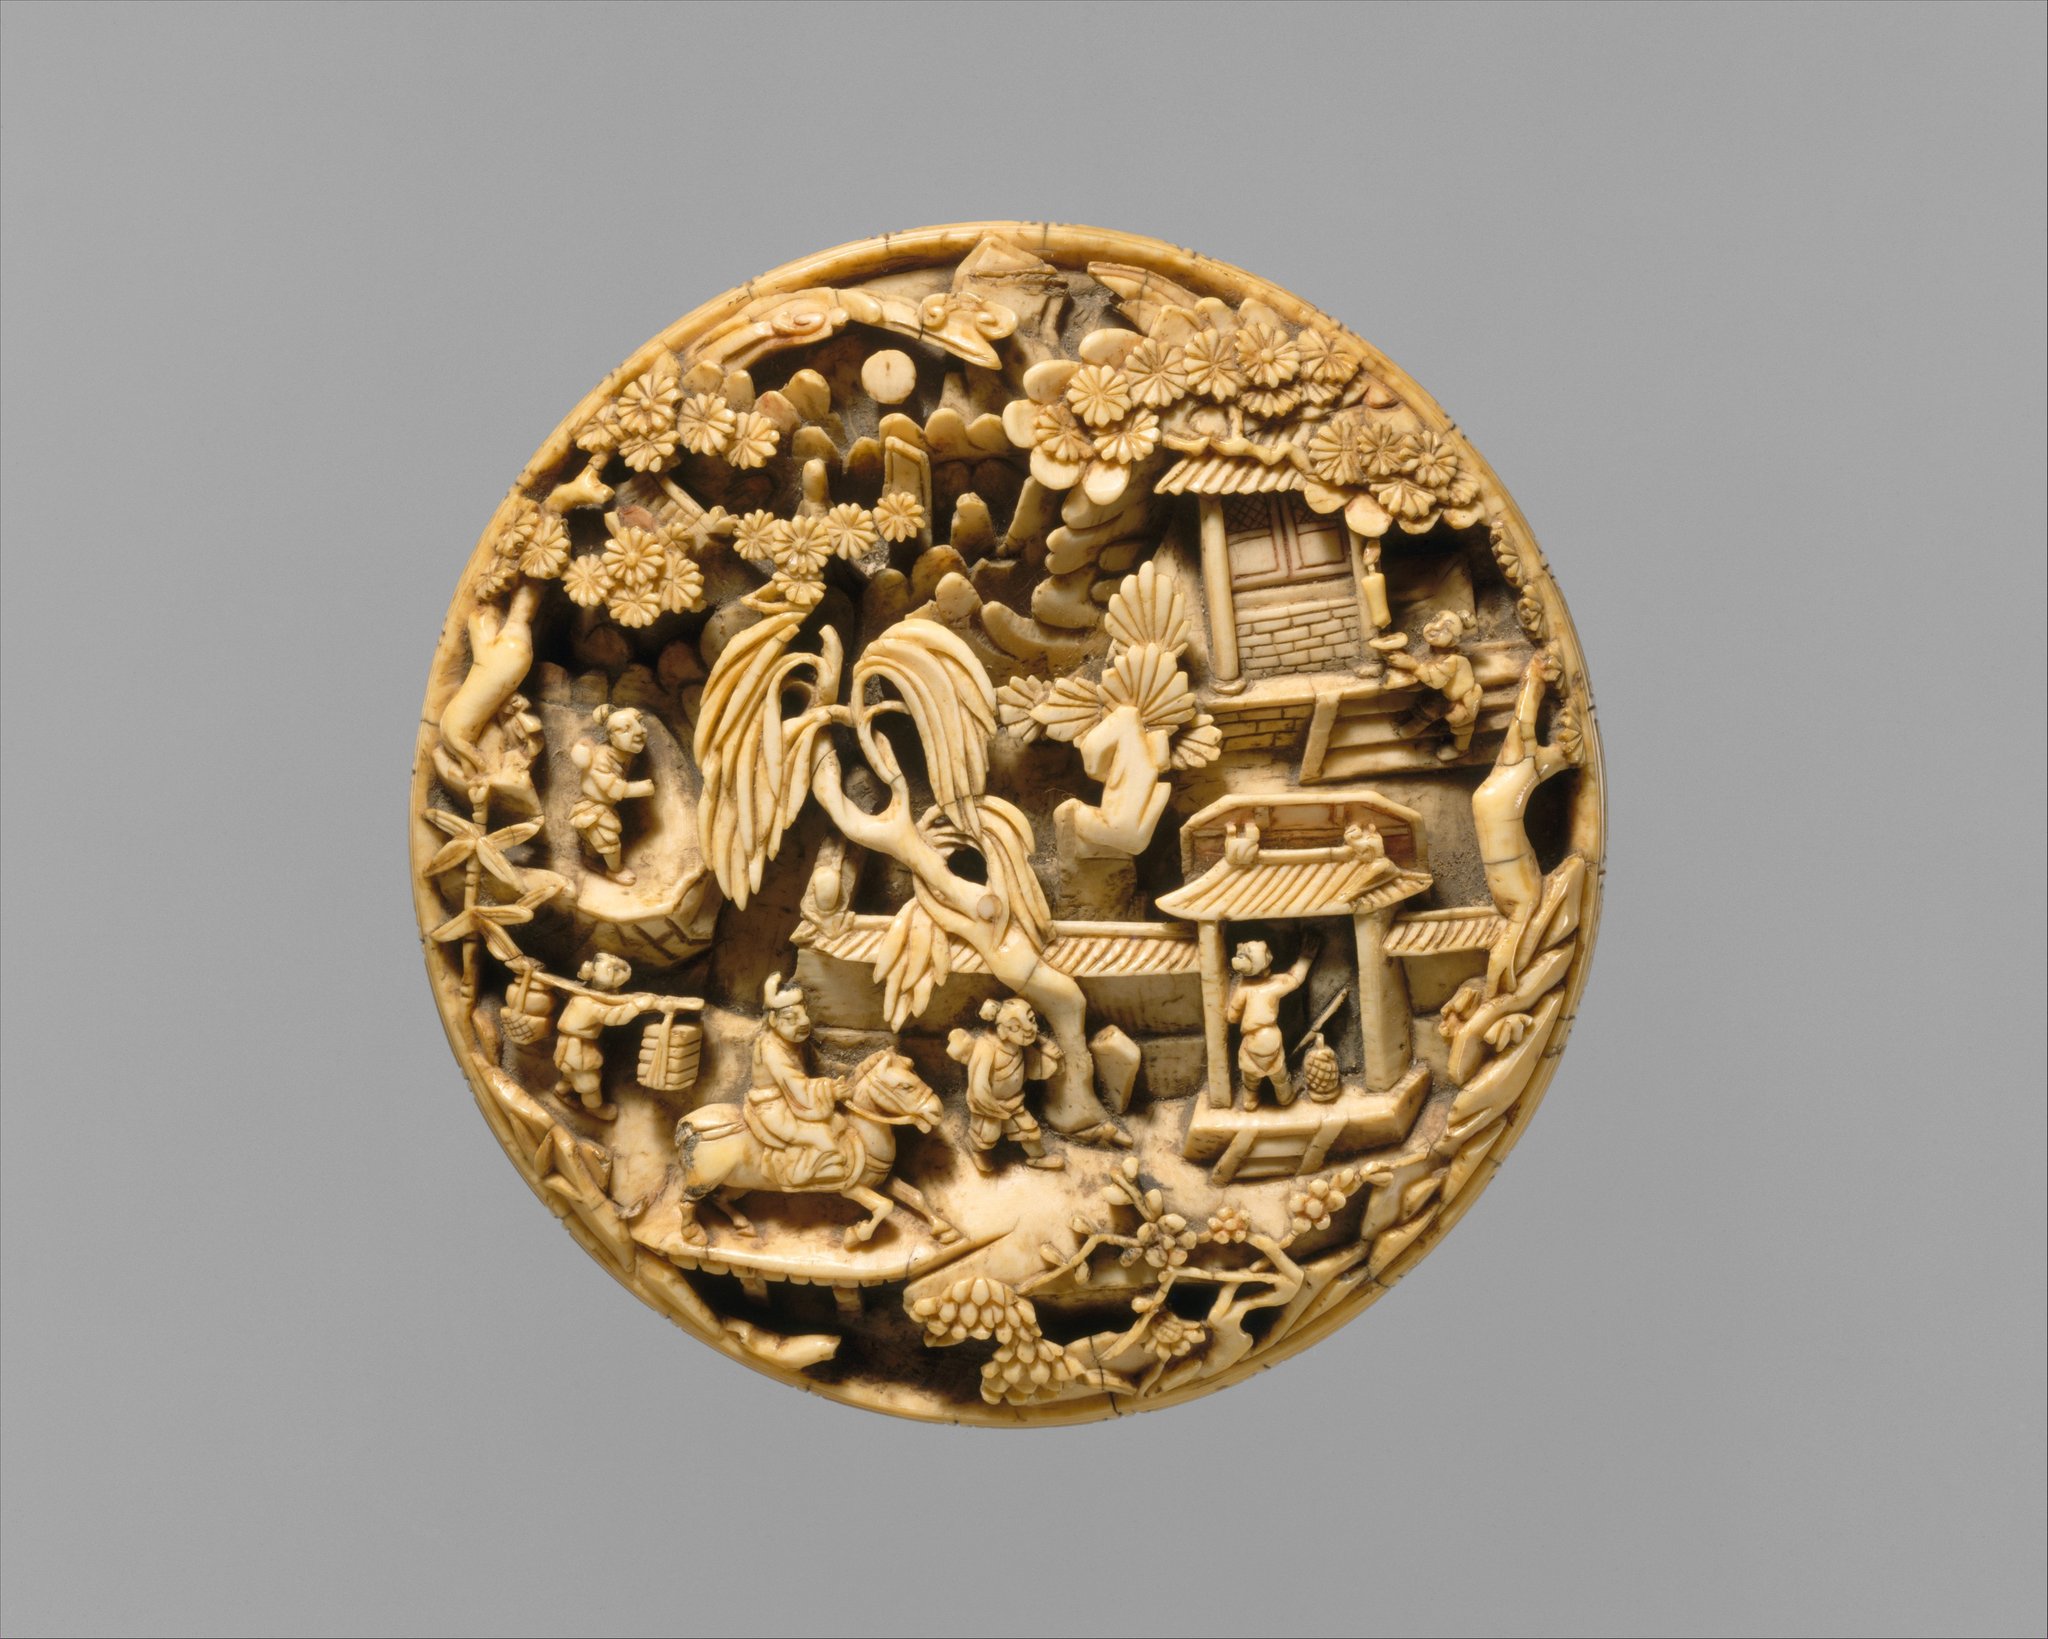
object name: medallion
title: Medallion with return from a spring outing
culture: chinese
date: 1567-1633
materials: ivory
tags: gates,horses,flowers,trees